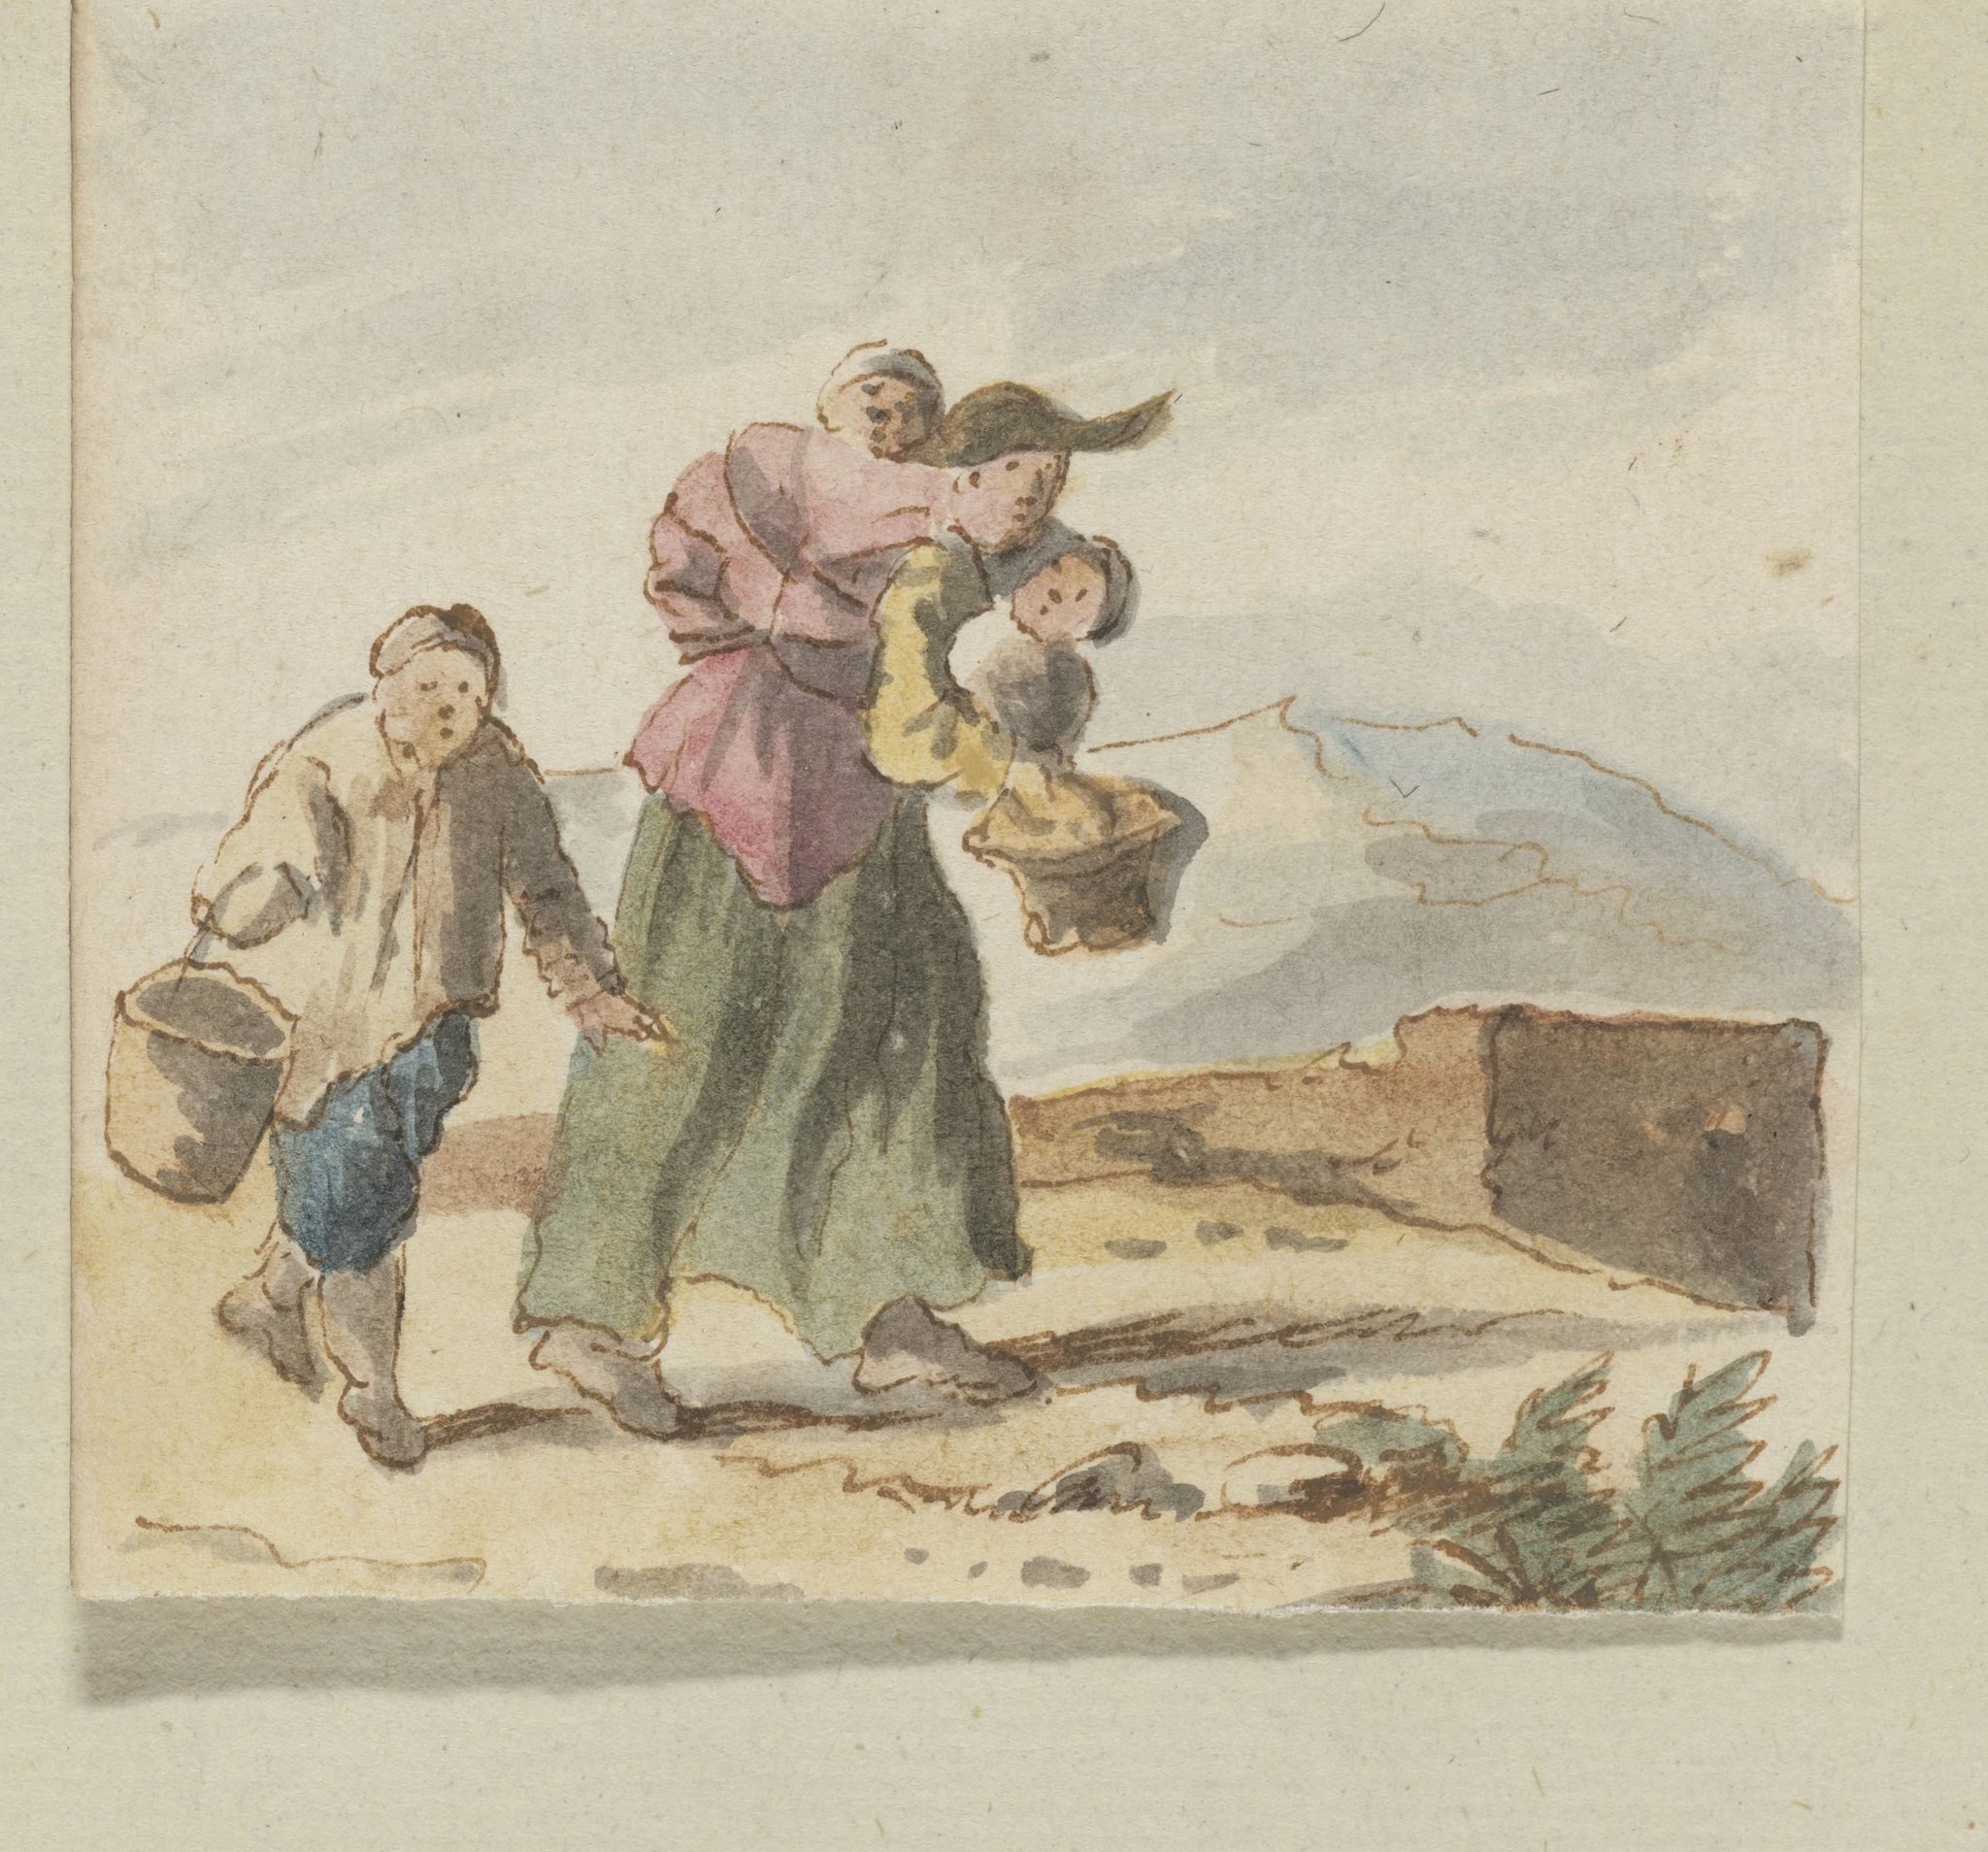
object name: drawing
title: Vrouw met drie kinderen in landschap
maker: Anonymous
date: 1700-1799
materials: ink, paper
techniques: brush, pen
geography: netherlands